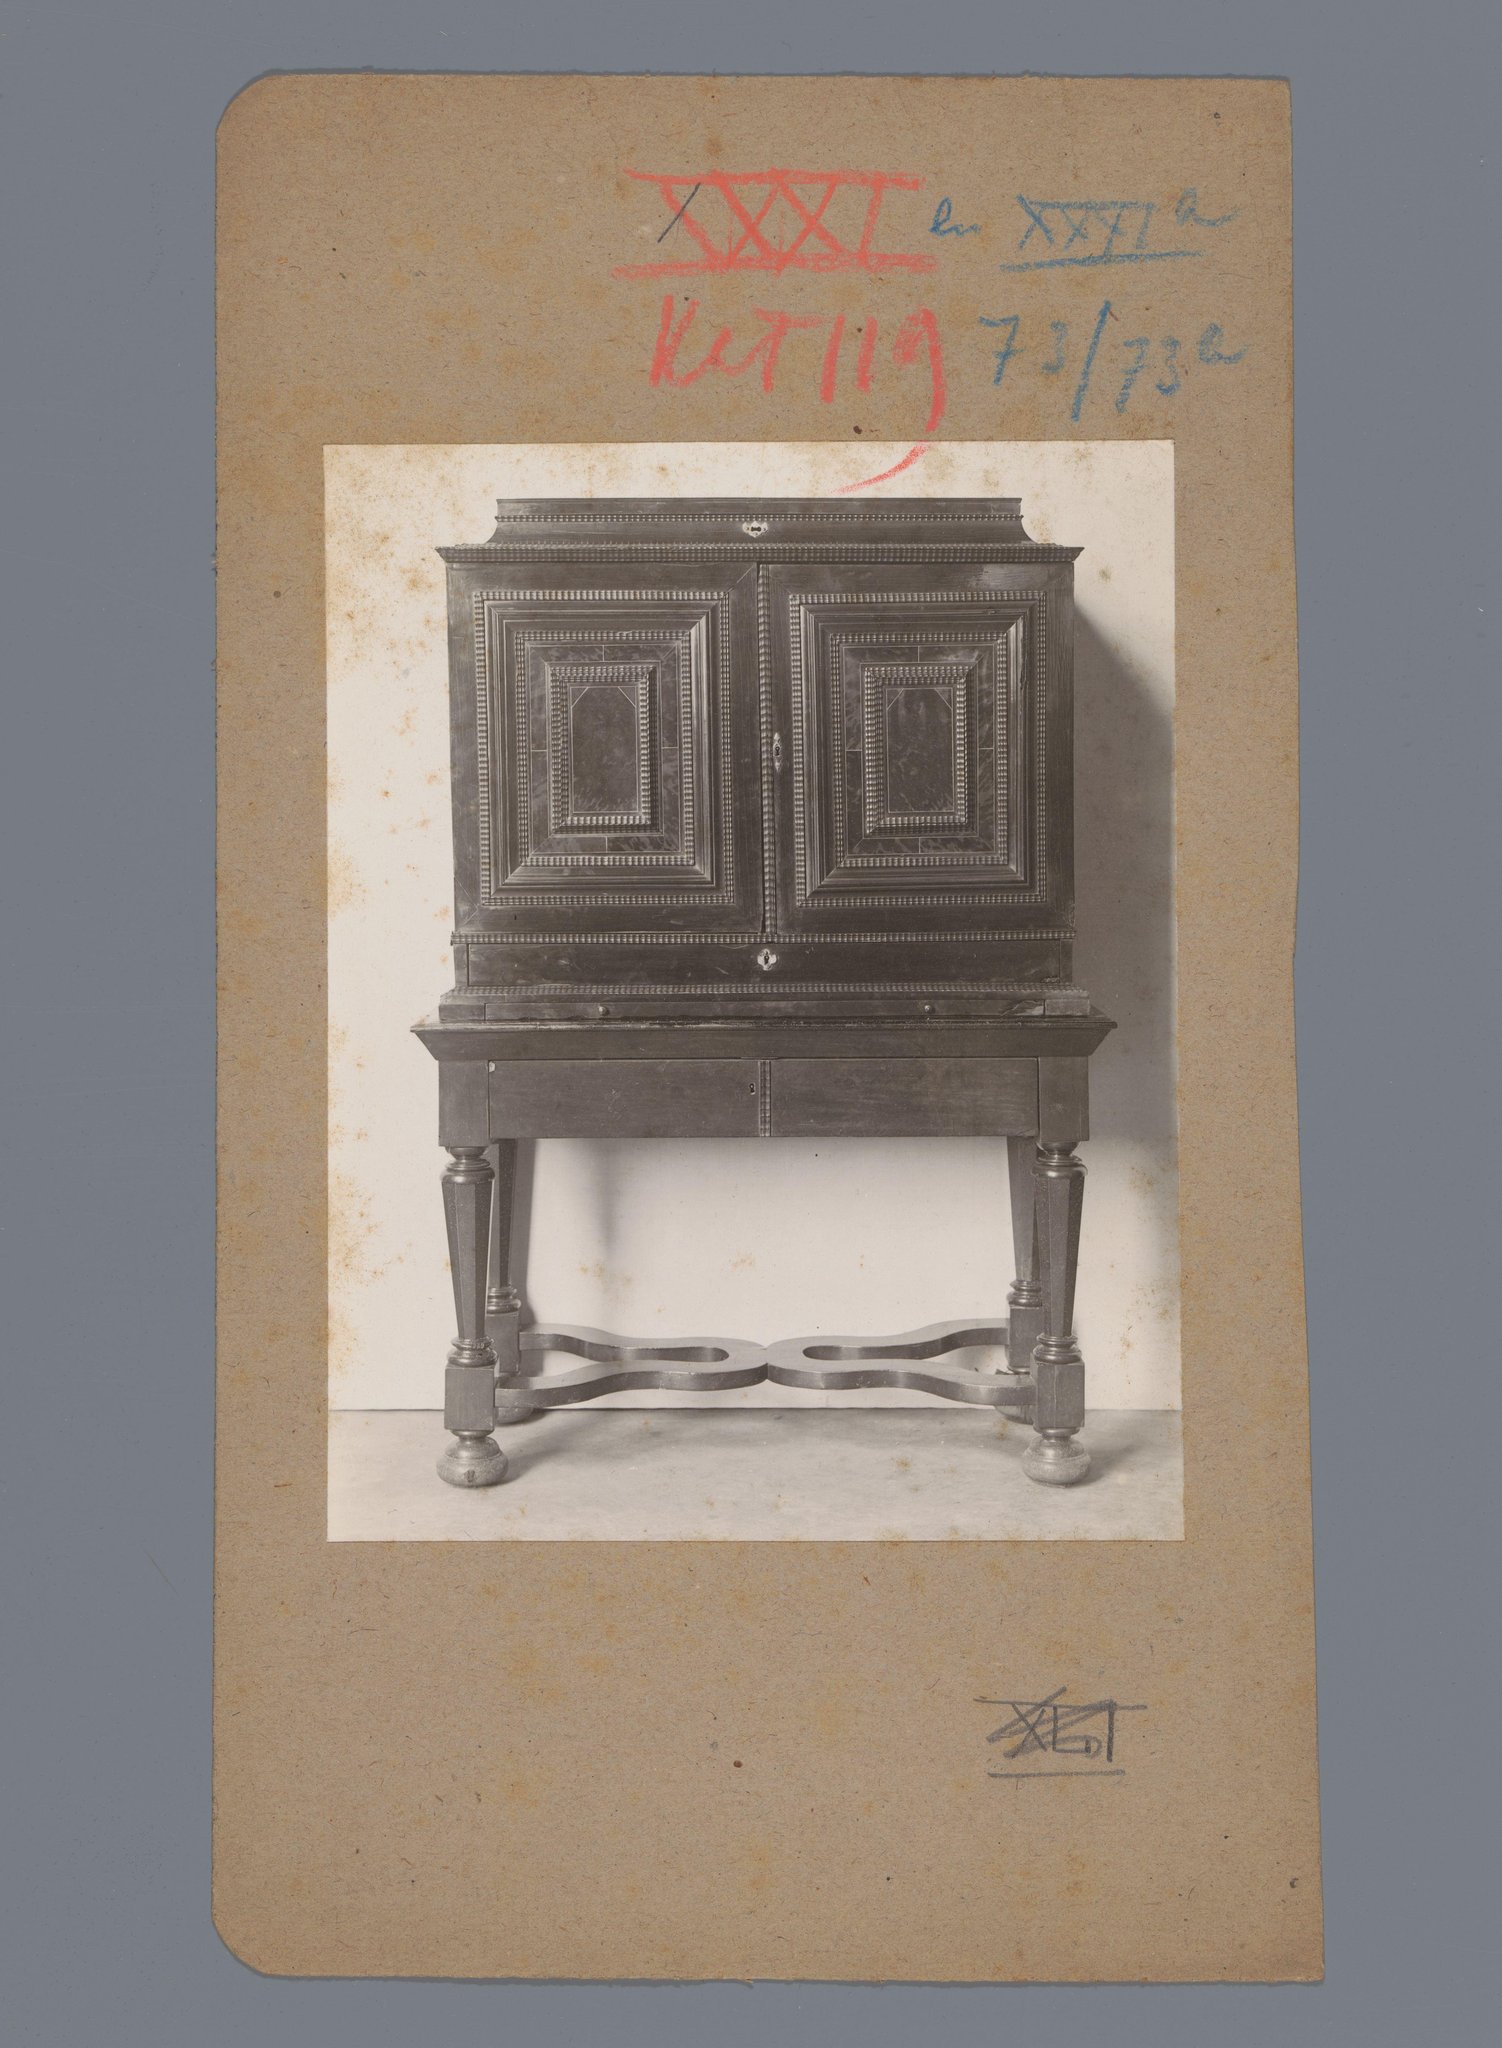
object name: photograph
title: Kunstkast in het Rijksmuseum te Amsterdam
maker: Anonymous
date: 1875-1900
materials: photographic support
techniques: matte daylight collodion silver print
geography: amsterdam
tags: 'kunstschrank'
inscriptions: collector's mark: ‘Kunstnijverheidschool Quellinus Amsterdam Frans Halsstraat 14.’, number: ‘XXXI en XXXI a Kat 119 73/73 a’, collector's mark: ‘Instituut voor kunst-nijverheidsonderwijs Gabriël Metsustraat No. 16, Amsterdam’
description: Zie voor het originele object BK-NM-11906-1.